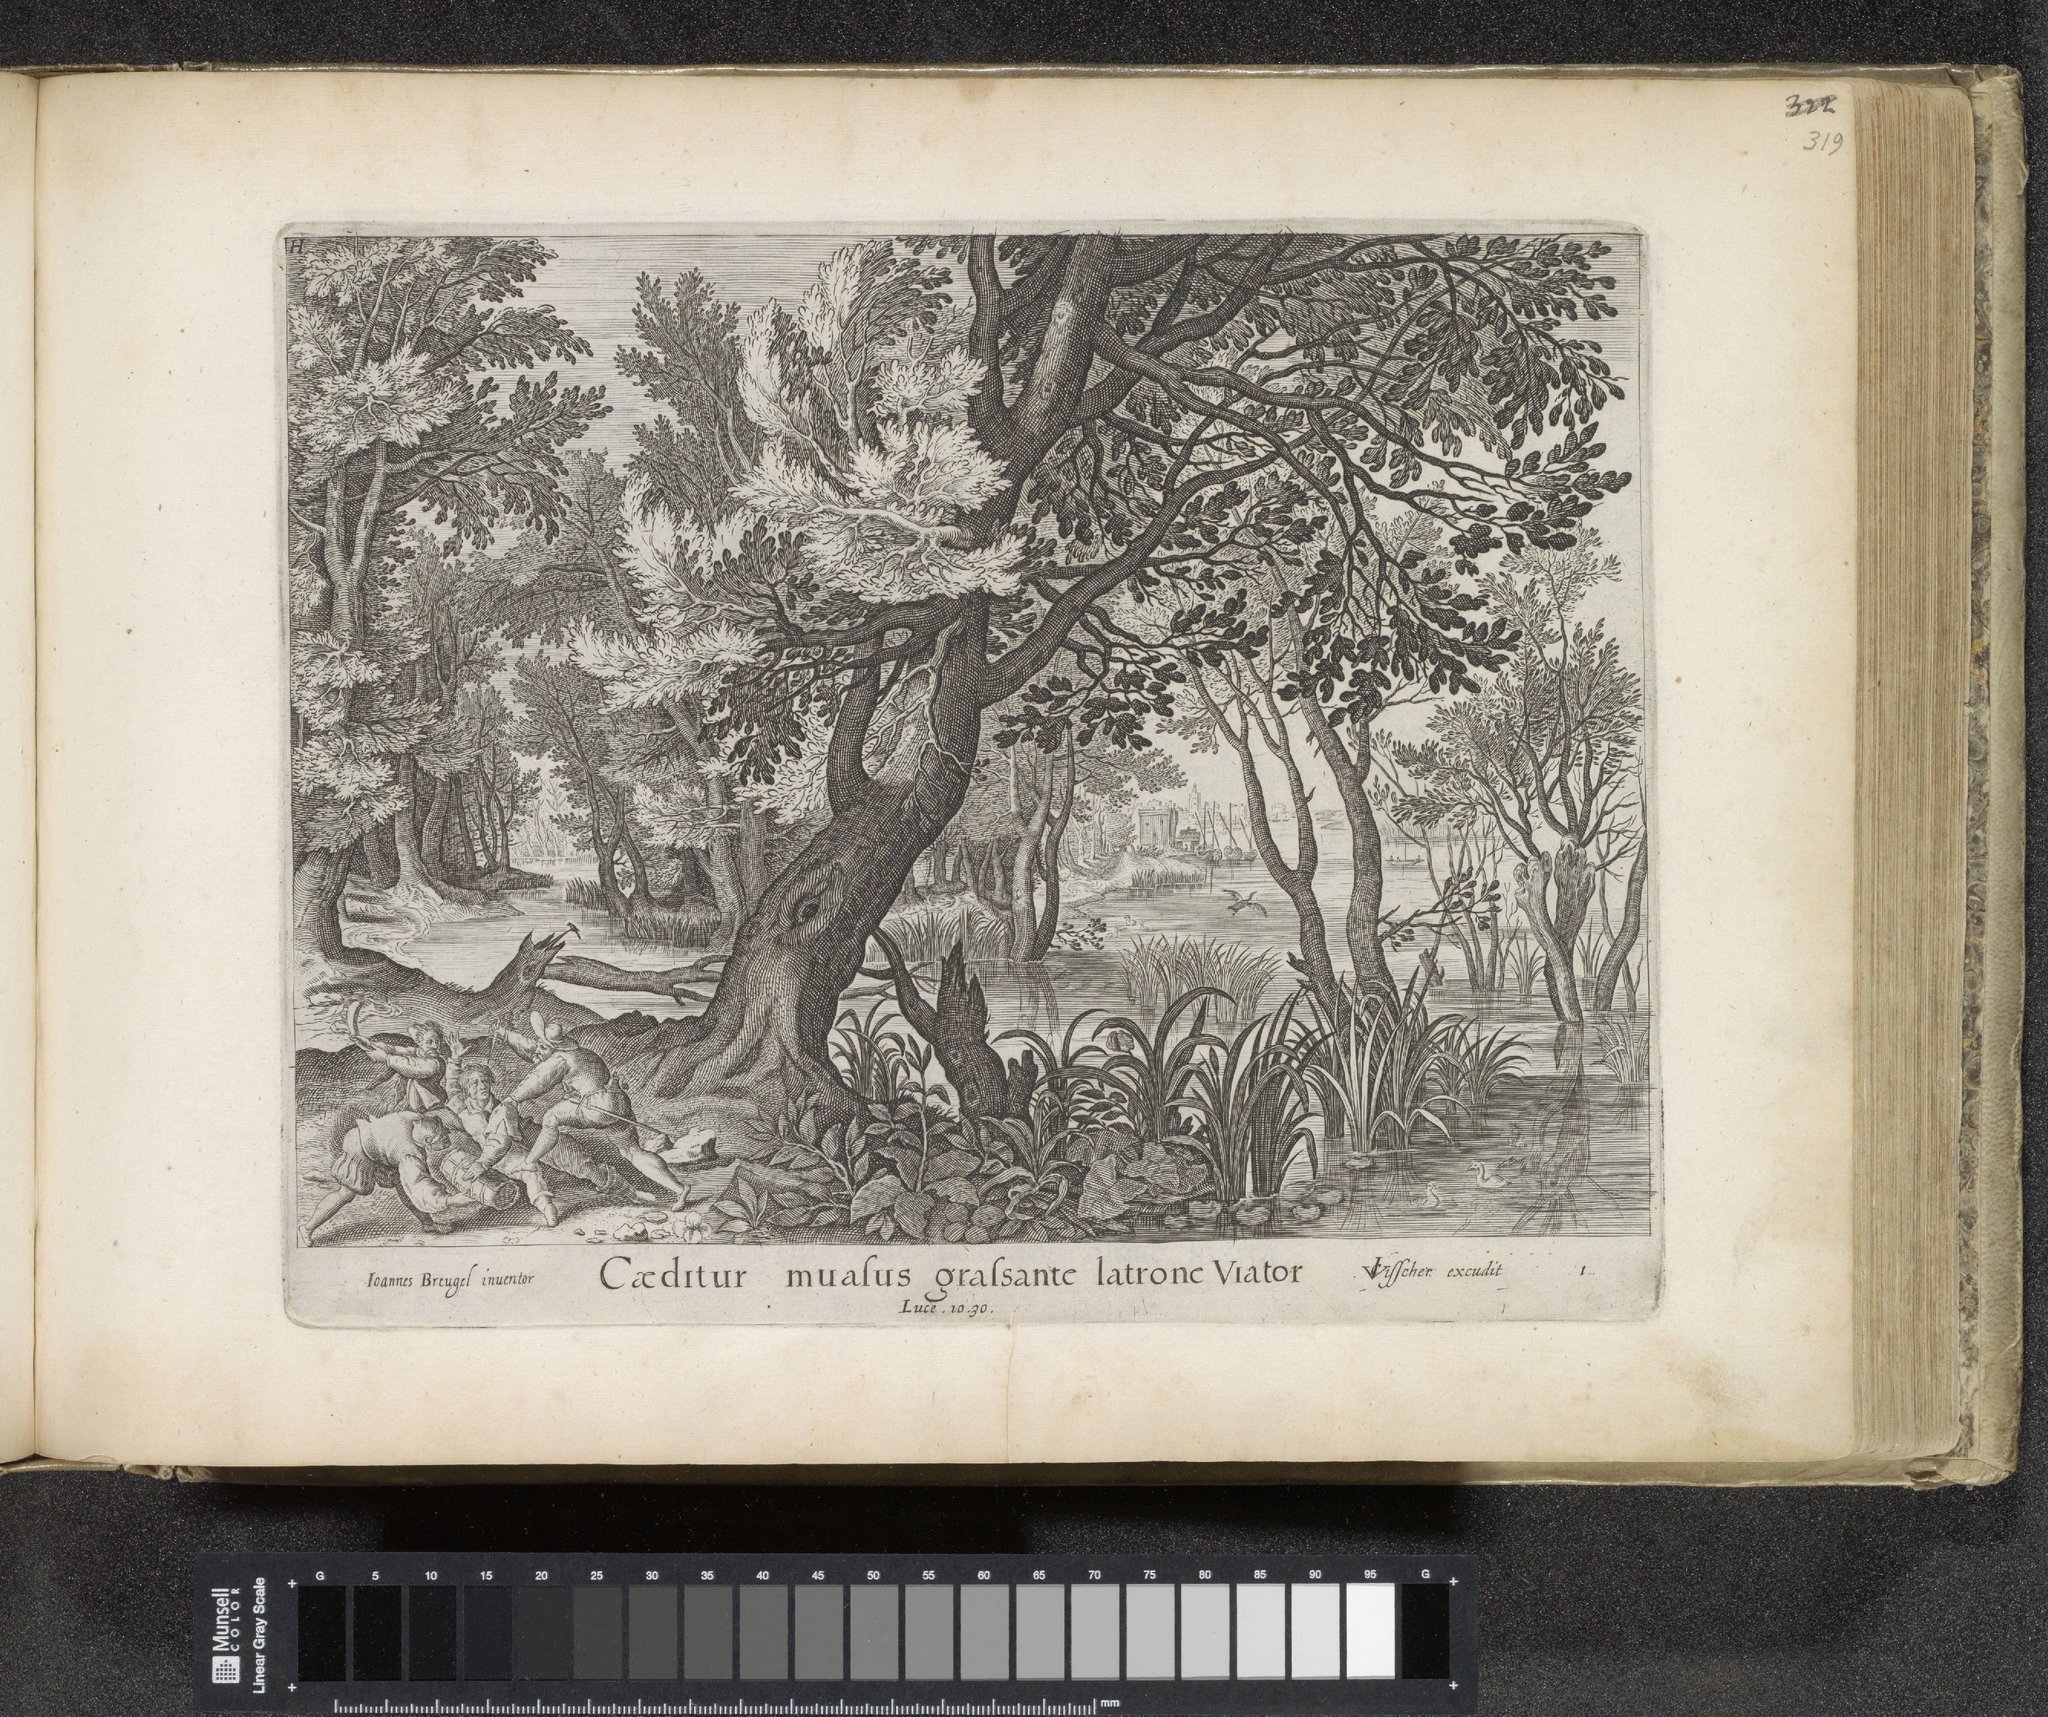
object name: album leaf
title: Theatrum Biblicum Hoc Est Historiae Sacrae Veteris et Novi Testamenti Tabulis Aeneis Expressae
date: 1643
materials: paper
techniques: engraving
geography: amsterdam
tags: the traveller is attacked by robbers ~ parable of the good samaritan, forest, wood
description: In een bosrijk rivierlandschap wordt een reiziger door drie rovers aangevallen en mishandeld. In de verte liggen enkele boten voor anker. Naar het Bijbelverhaal in Luc. 10: 25-37. Deze prent maakt deel uit van een album.